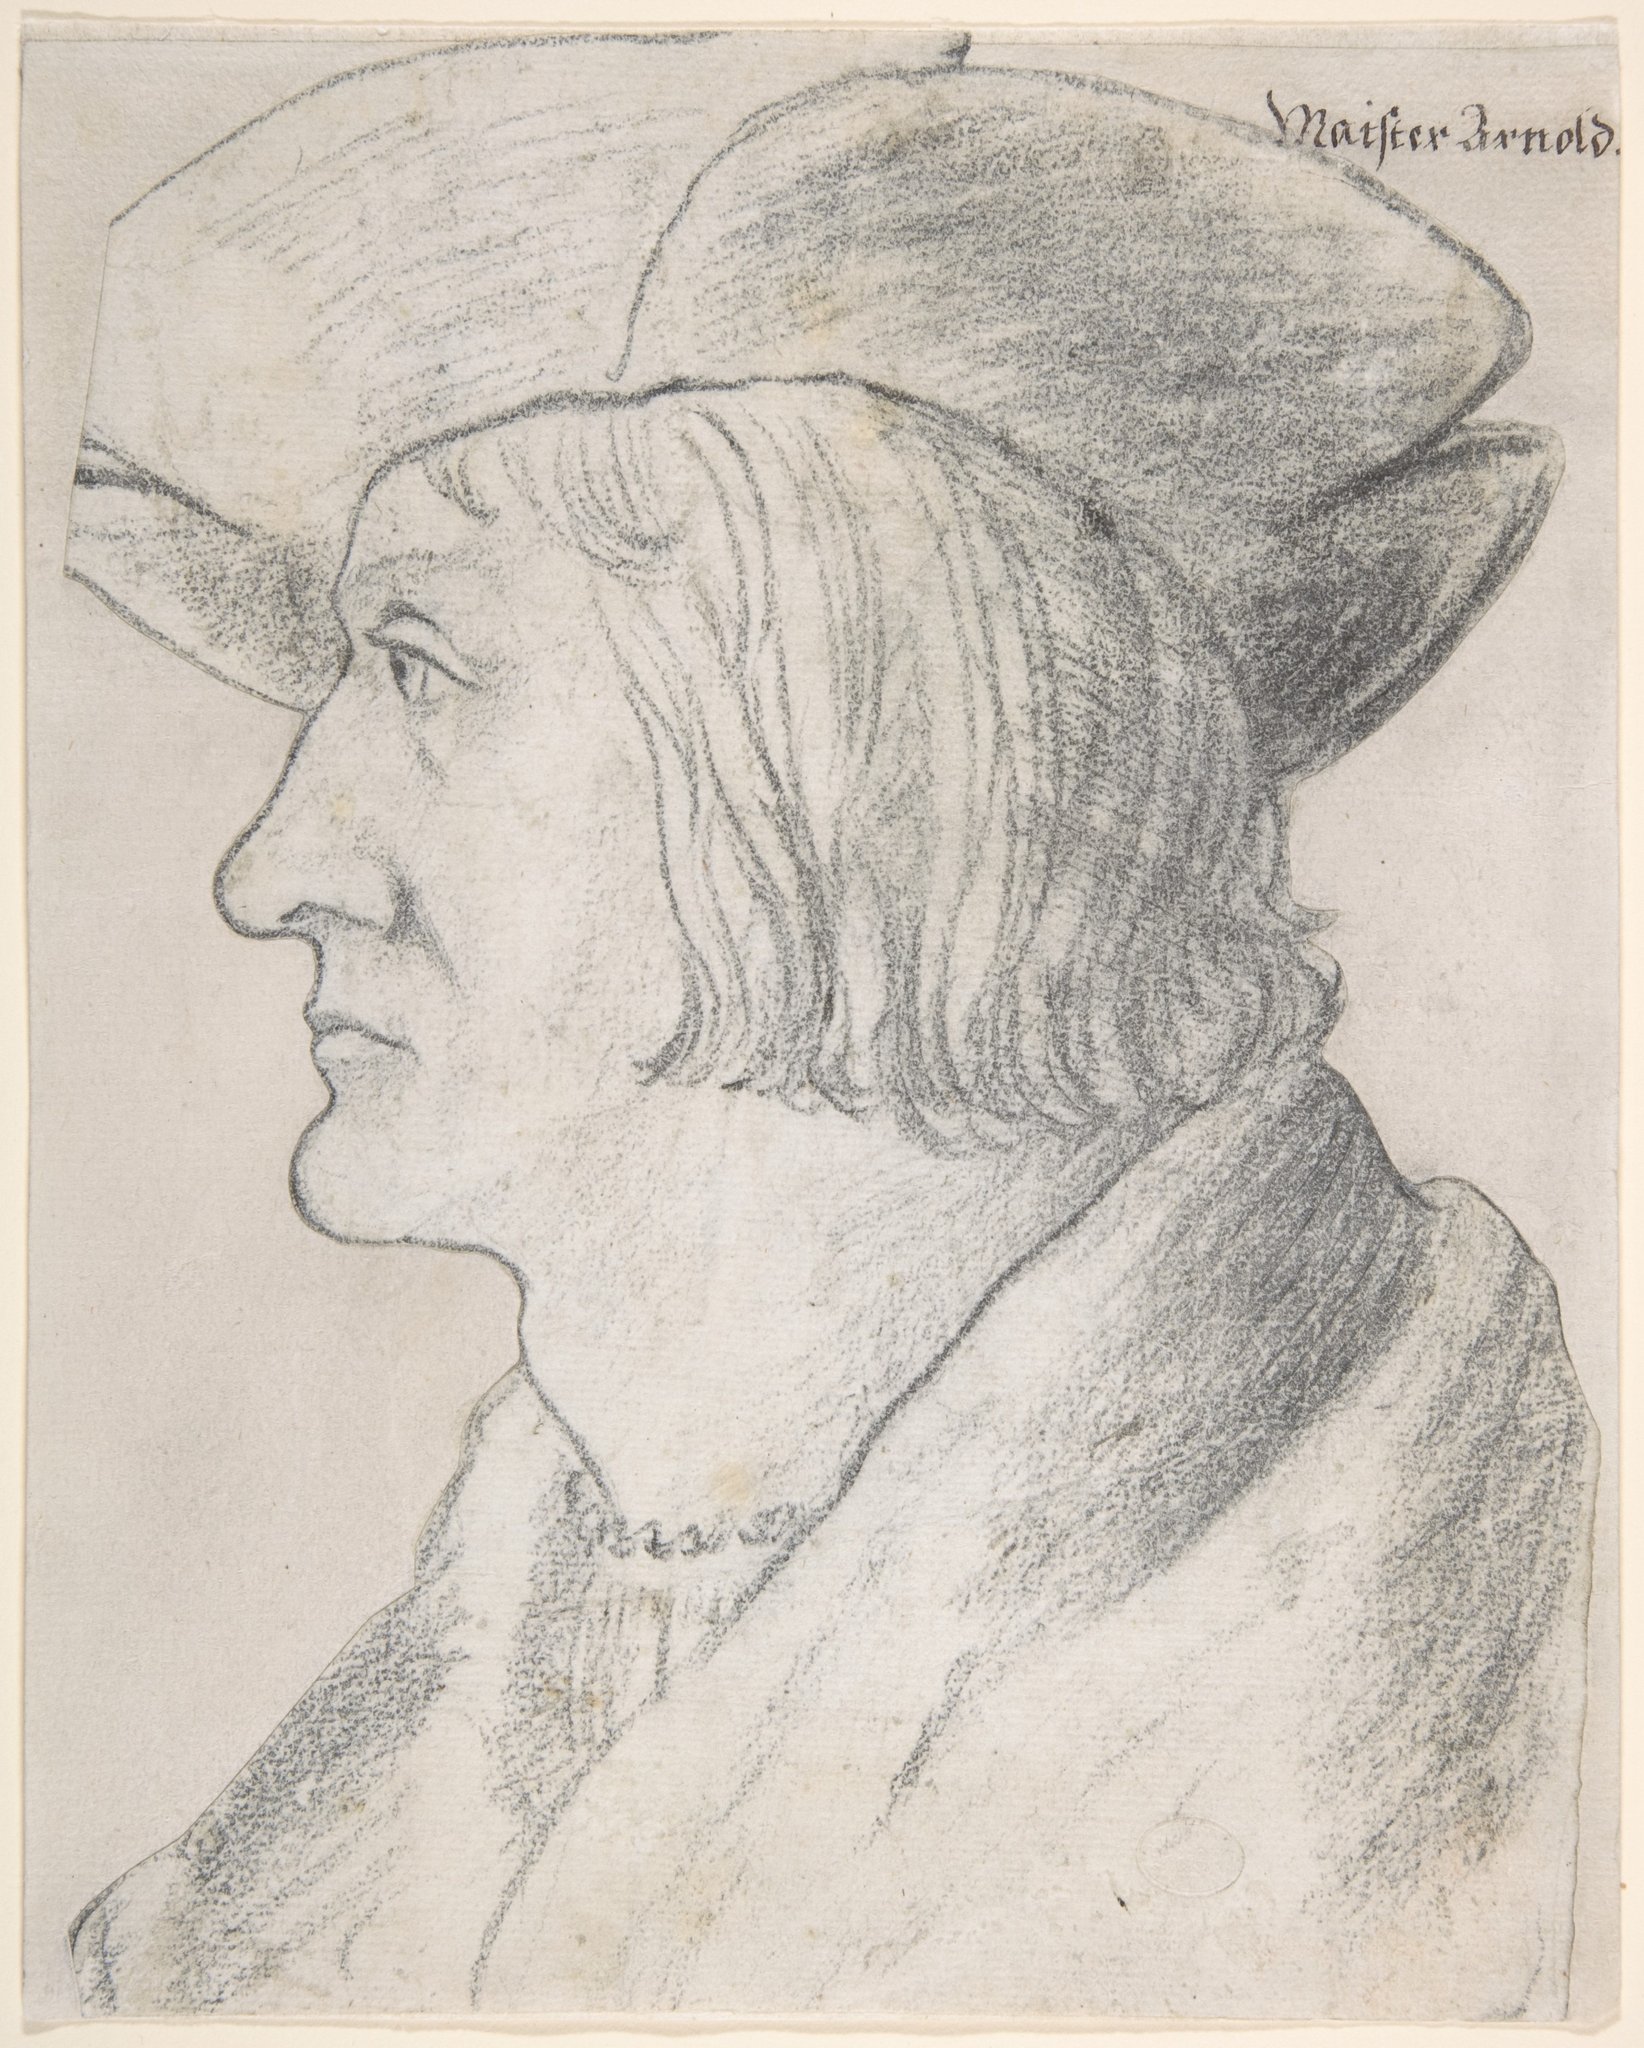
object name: drawing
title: Portrait of Simon von Liebenstein (?)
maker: hans schwarz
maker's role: artist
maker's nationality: german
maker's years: 1492-1521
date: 1516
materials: charcoal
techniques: cutting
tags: men,portraits,profiles